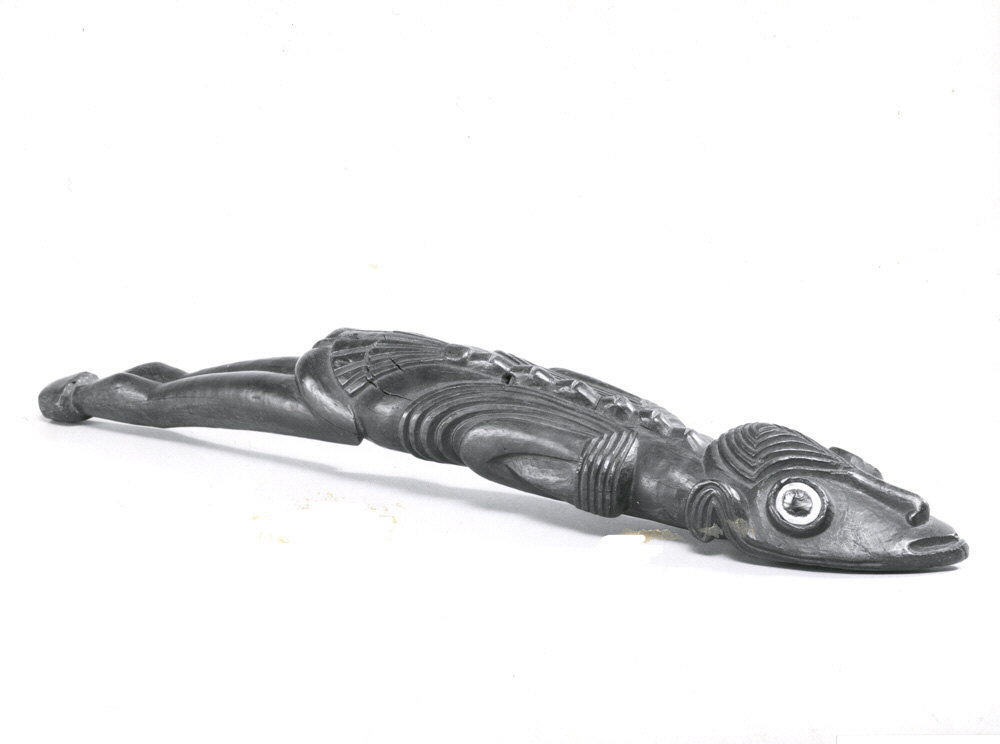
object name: figure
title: Lizard Man Figure (Moko)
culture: rapa nui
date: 1867-1900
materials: bone, obsidian, wood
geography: chile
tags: men,lizards